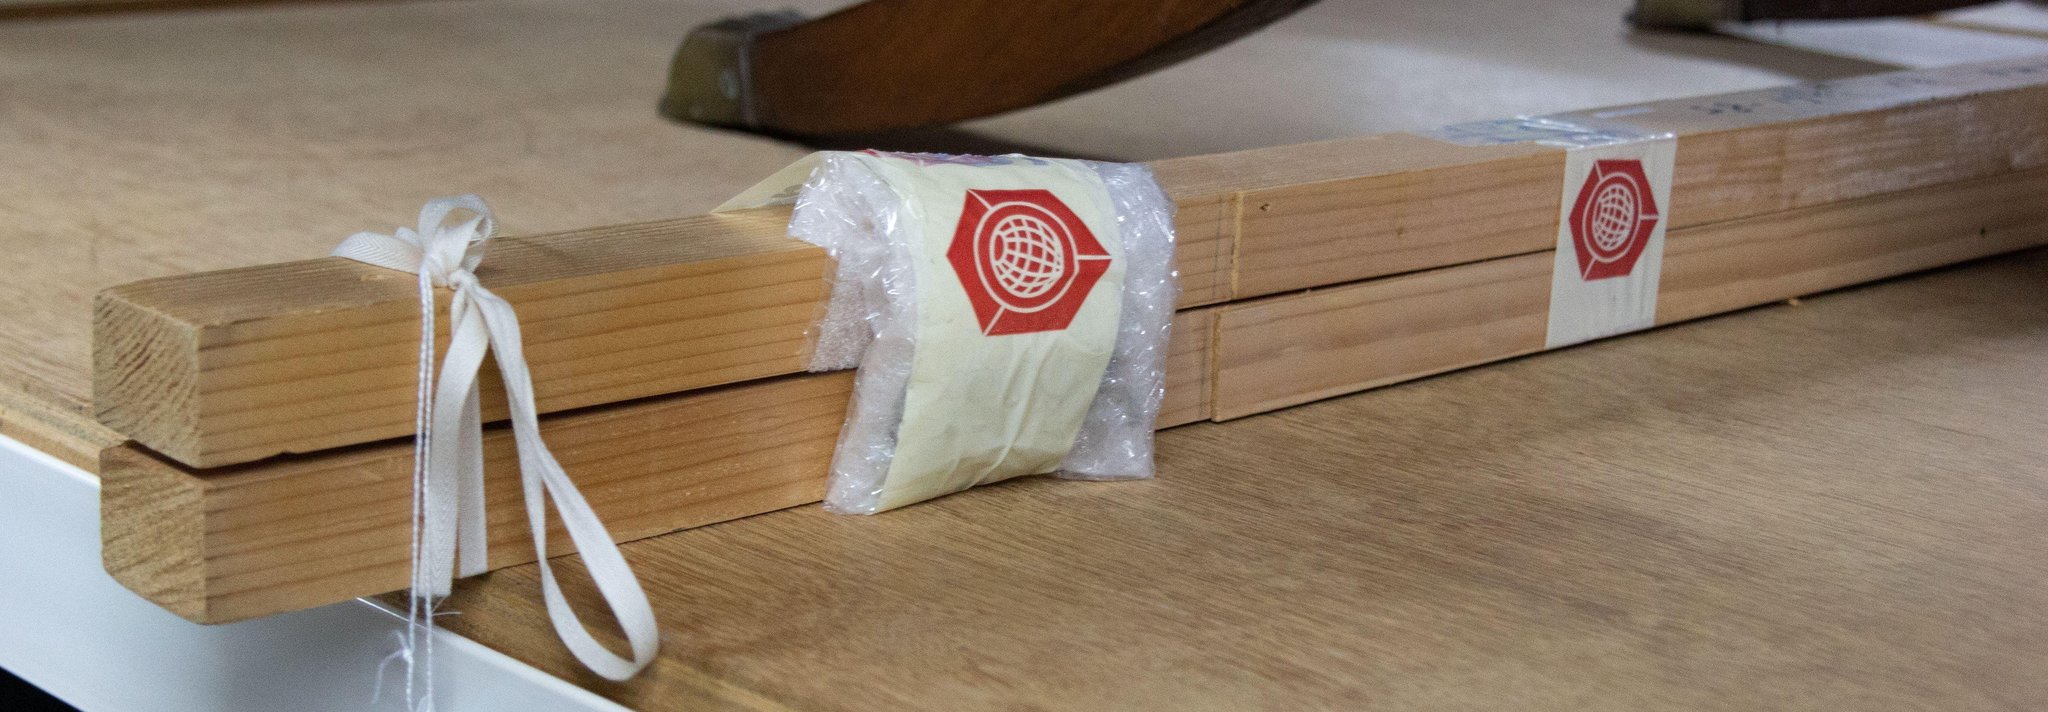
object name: furniture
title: Twee houten balken voor verlengen tafel met ovaal blad en schraagvormige poten die eindigen in klauwen van koper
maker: Anonymous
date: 1800-1815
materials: wood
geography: dutch east indies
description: Twee houten balken voor verlengen tafel met ovaal blad en schraagvormige poten die eindigen in klauwen van koper